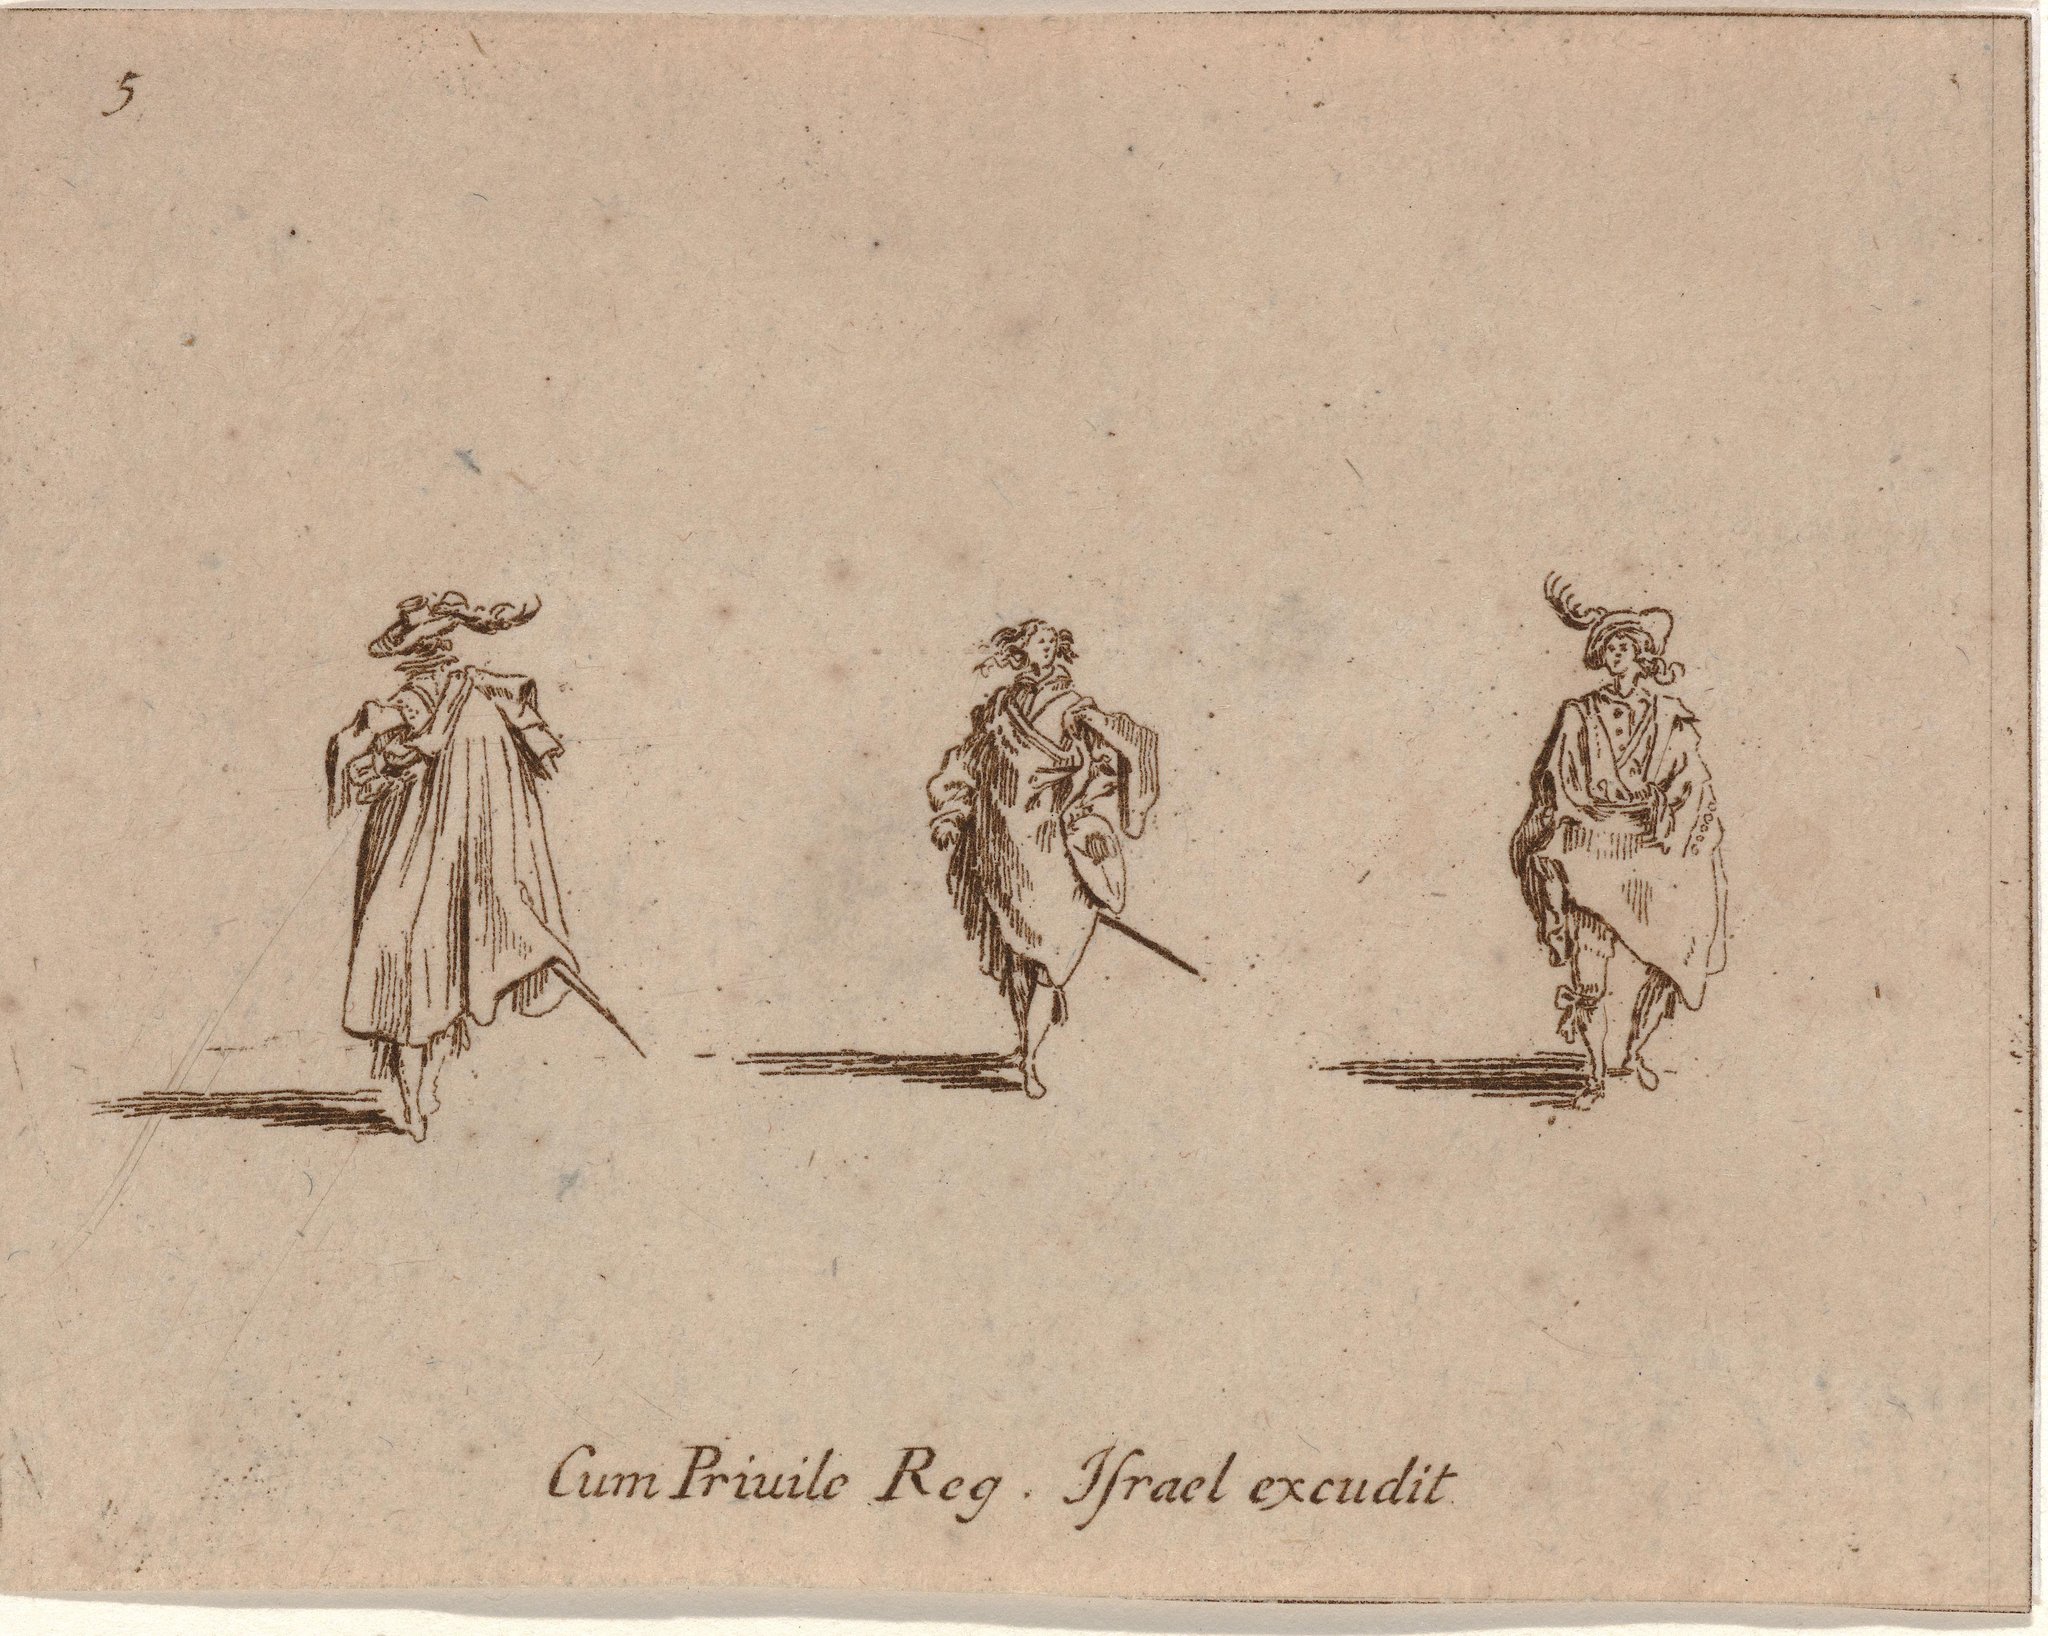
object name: print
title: Drie figuurtjes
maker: israël henriet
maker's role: printer, publisher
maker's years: 1590-1661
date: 1635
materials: paper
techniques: etching